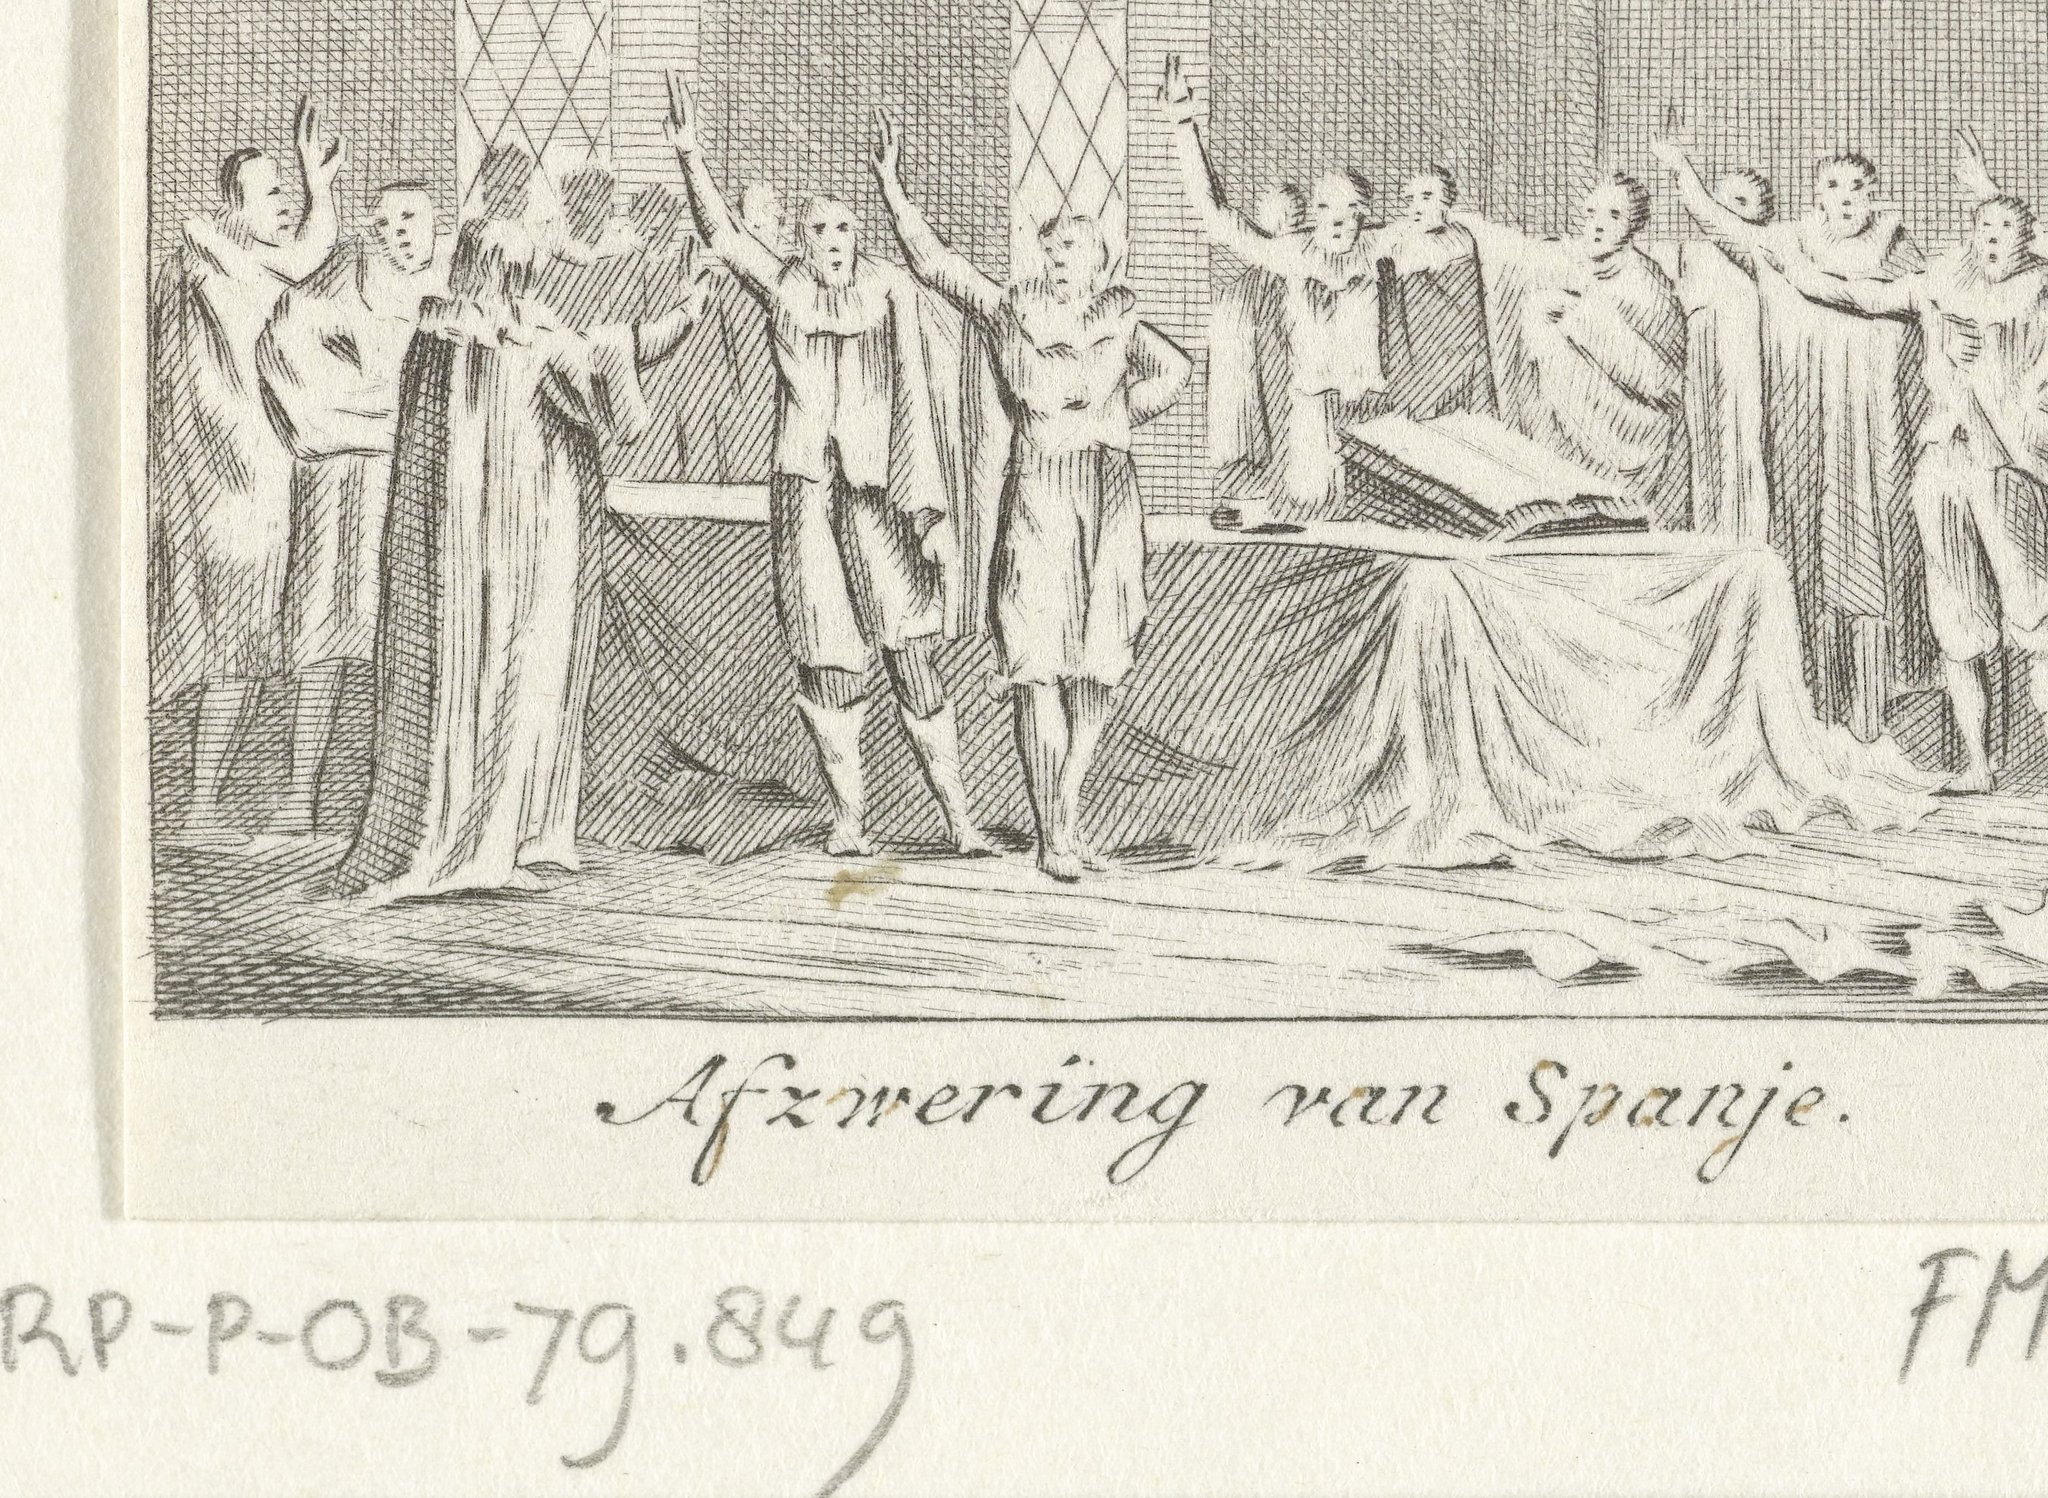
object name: print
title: Afzwering van Spanje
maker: Anonymous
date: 1700-1799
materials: paper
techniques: engraving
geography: netherlands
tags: philip ii of spain, involuntary abdication (of a ruler), swearing an oath (with two fingers raised)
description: Kleine voorstelling van het afzweren van de Spaanse koning Filips II door de Staten, 26 juli 1581. Interieur waarin een grote groep van leden van de Staten-Generaal de eed afleggen.